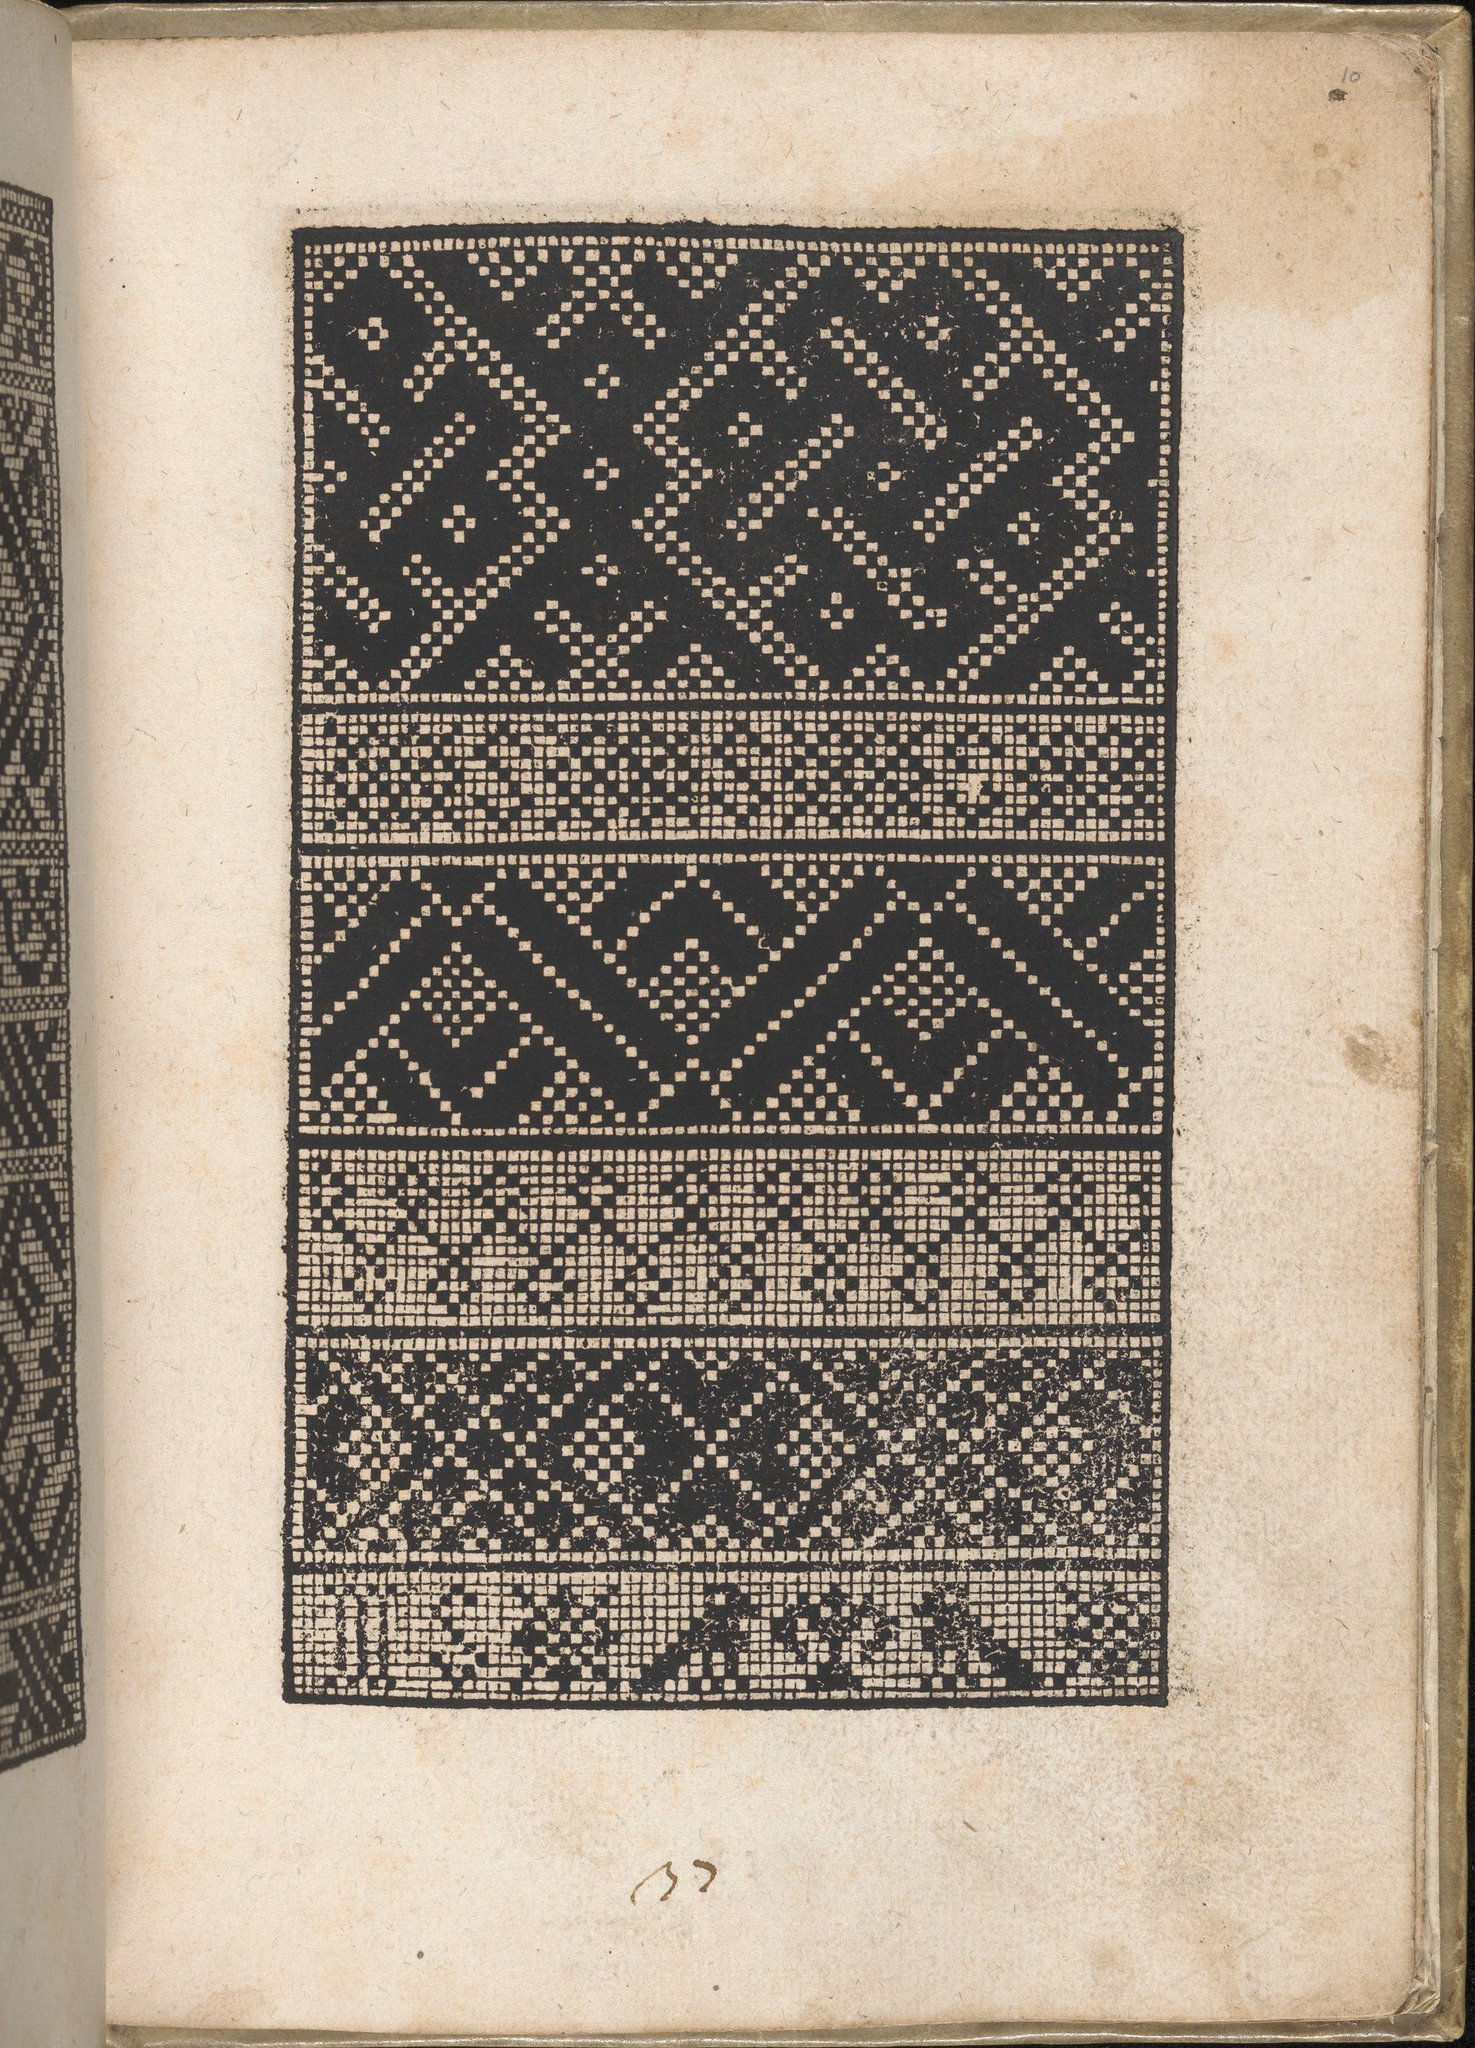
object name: book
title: Page 11r, from "Eyn New Kunstlichboich"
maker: peter quentel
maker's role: publisher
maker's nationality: german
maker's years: 1500-1550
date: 1529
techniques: woodcut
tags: ornament